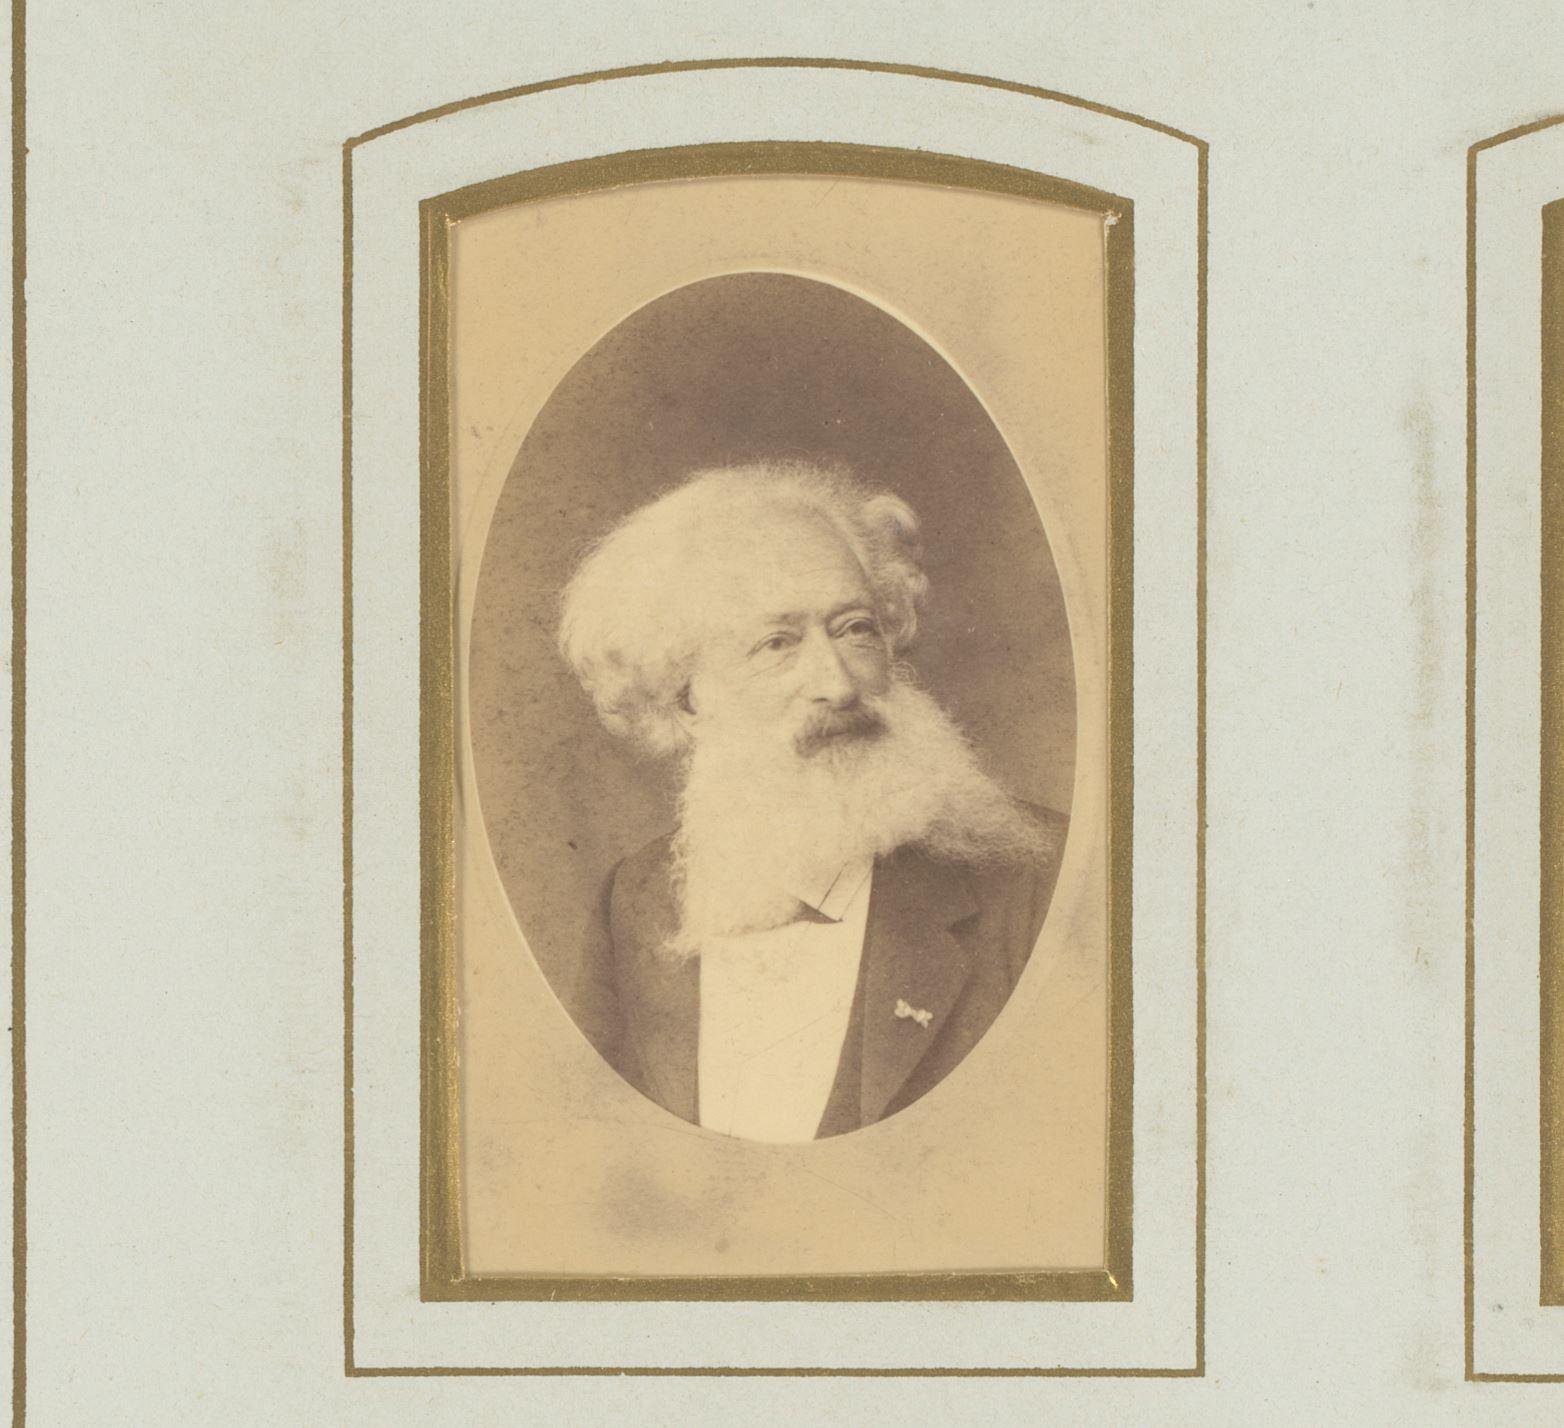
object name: semi enamel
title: Portret van een man met snor en baard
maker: eugène pirou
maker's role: fotograaf, fotostudio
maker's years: 1841-1909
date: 1864-1904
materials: cardboard, celluloid, photographic support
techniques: albumen print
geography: paris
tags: moustache, historical persons, beard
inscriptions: inscription: ‘Eugène Pirou/ Photographie/ 3 Bard St GERMAIN/ PARIS’